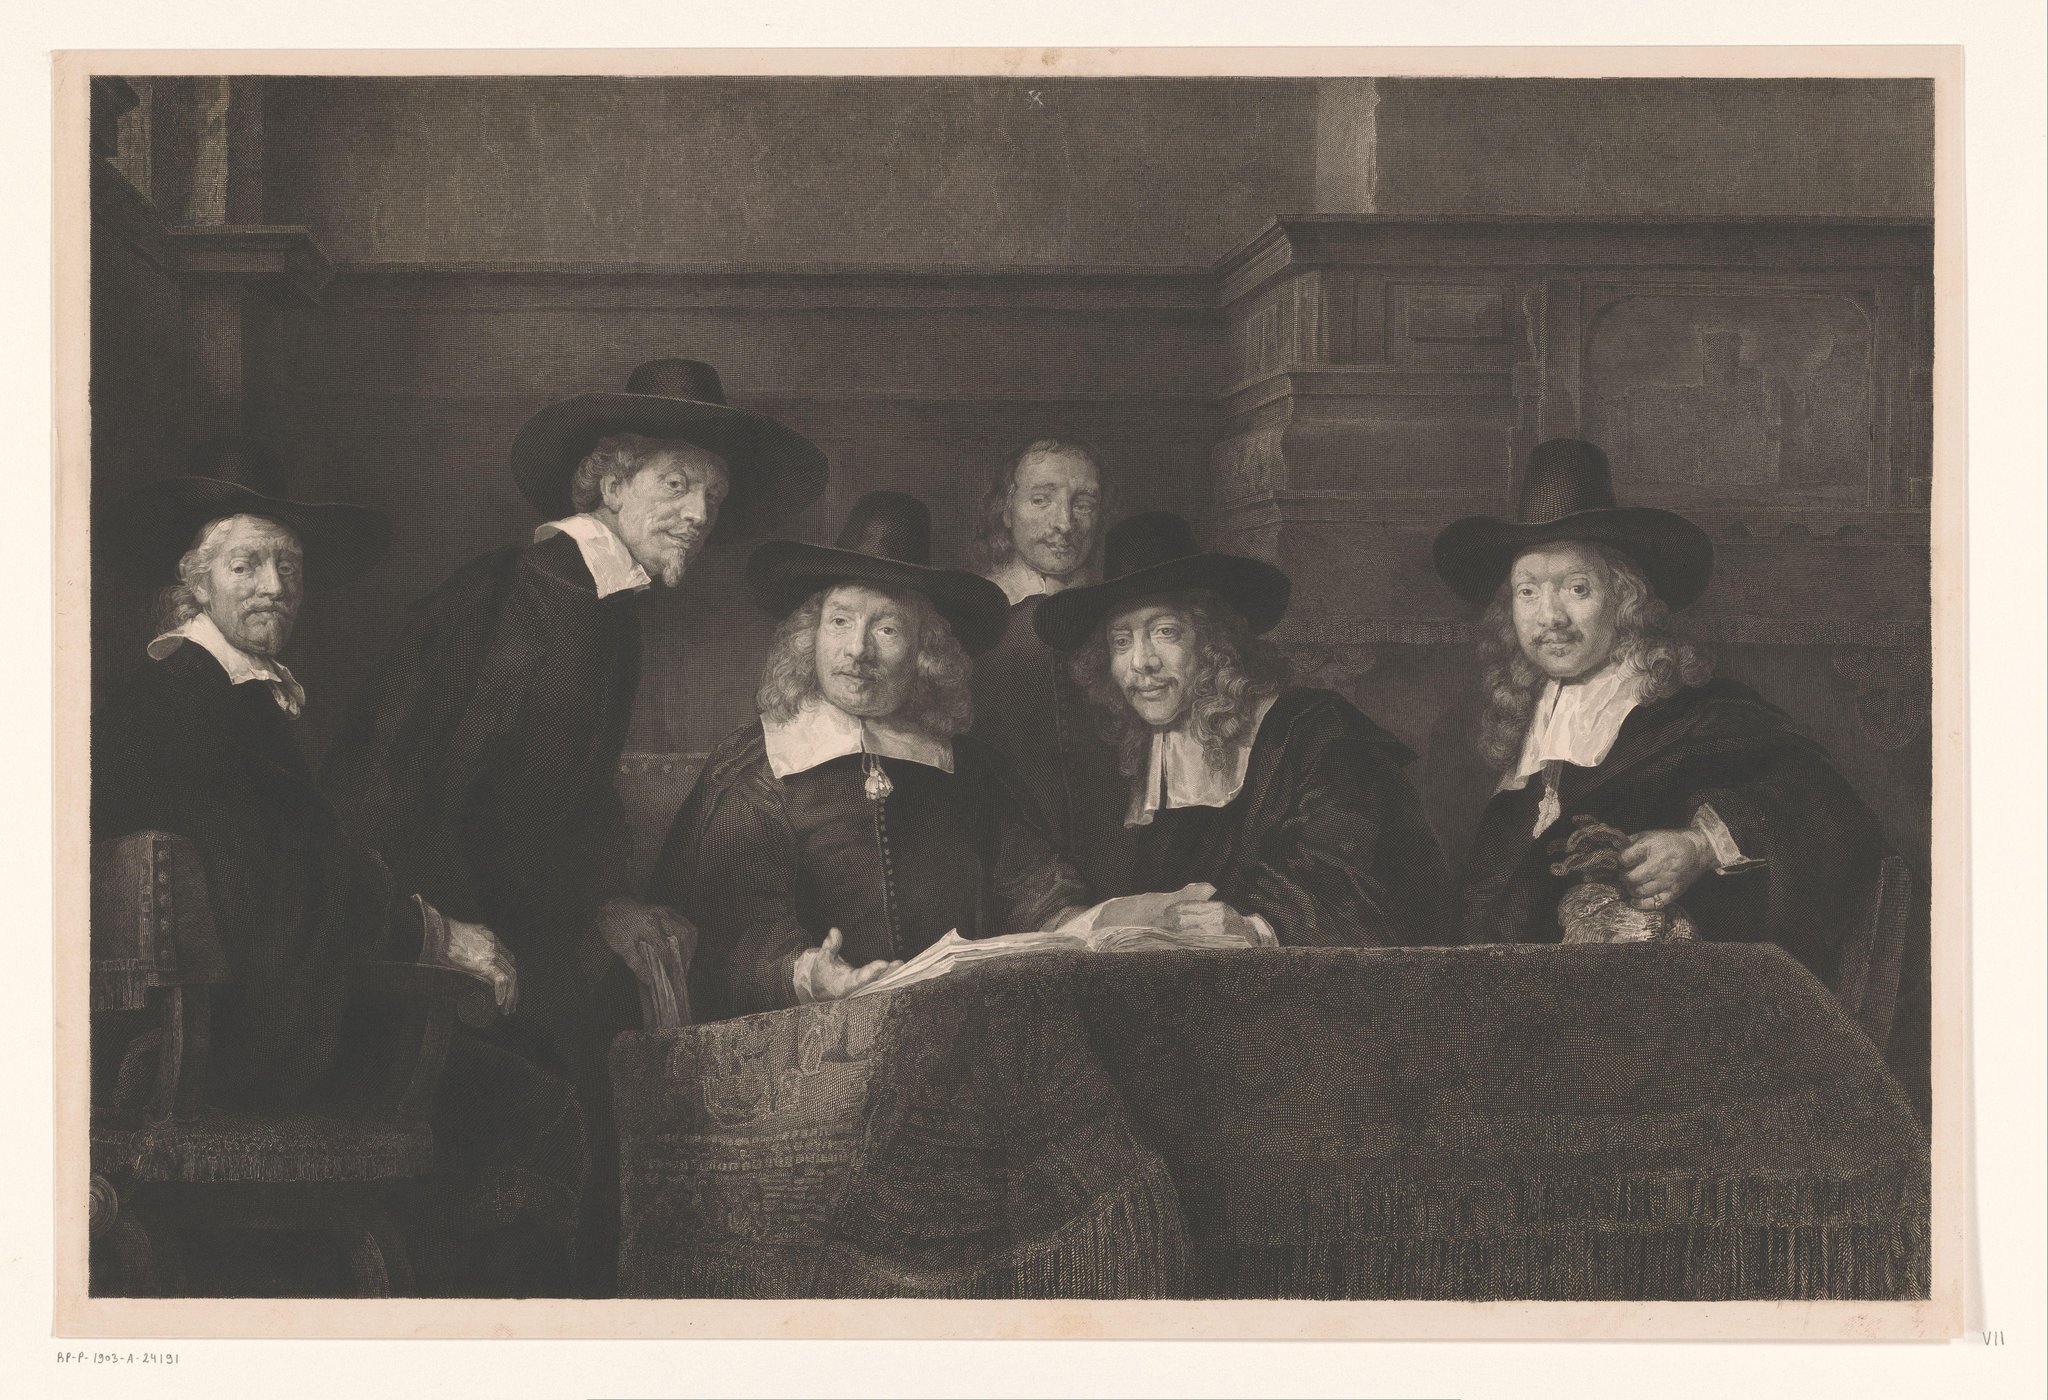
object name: print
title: De waardijns van het Amsterdamse lakenbereidersgilde, bekend als ‘De Staalmeesters’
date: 1846-1900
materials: paper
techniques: engraving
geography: netherlands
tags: control of quality, amsterdam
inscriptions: collector's mark: Lugt 2228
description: De Staalmeesters: het college van staalmeesters of waardijns van het Amsterdamse lakenbereidersgilde, bijeen rond een tafel waarop een Perzisch kleed ligt. Op tafel het opengeslagen stalenboek. Voorgesteld zijn van links naar rechts: Jochem de Neve (1629-81), Aernout van der Mye (ca. 1625-81), de knecht Frans Hendricksz Bel (1629-1701), Willem van Doeyenburg (ca. 1616-87), Volckert Jansz (1605/10-81), Jacob van Loon (1595-1674). Links boven de haard een schilderij met een brandend baken.